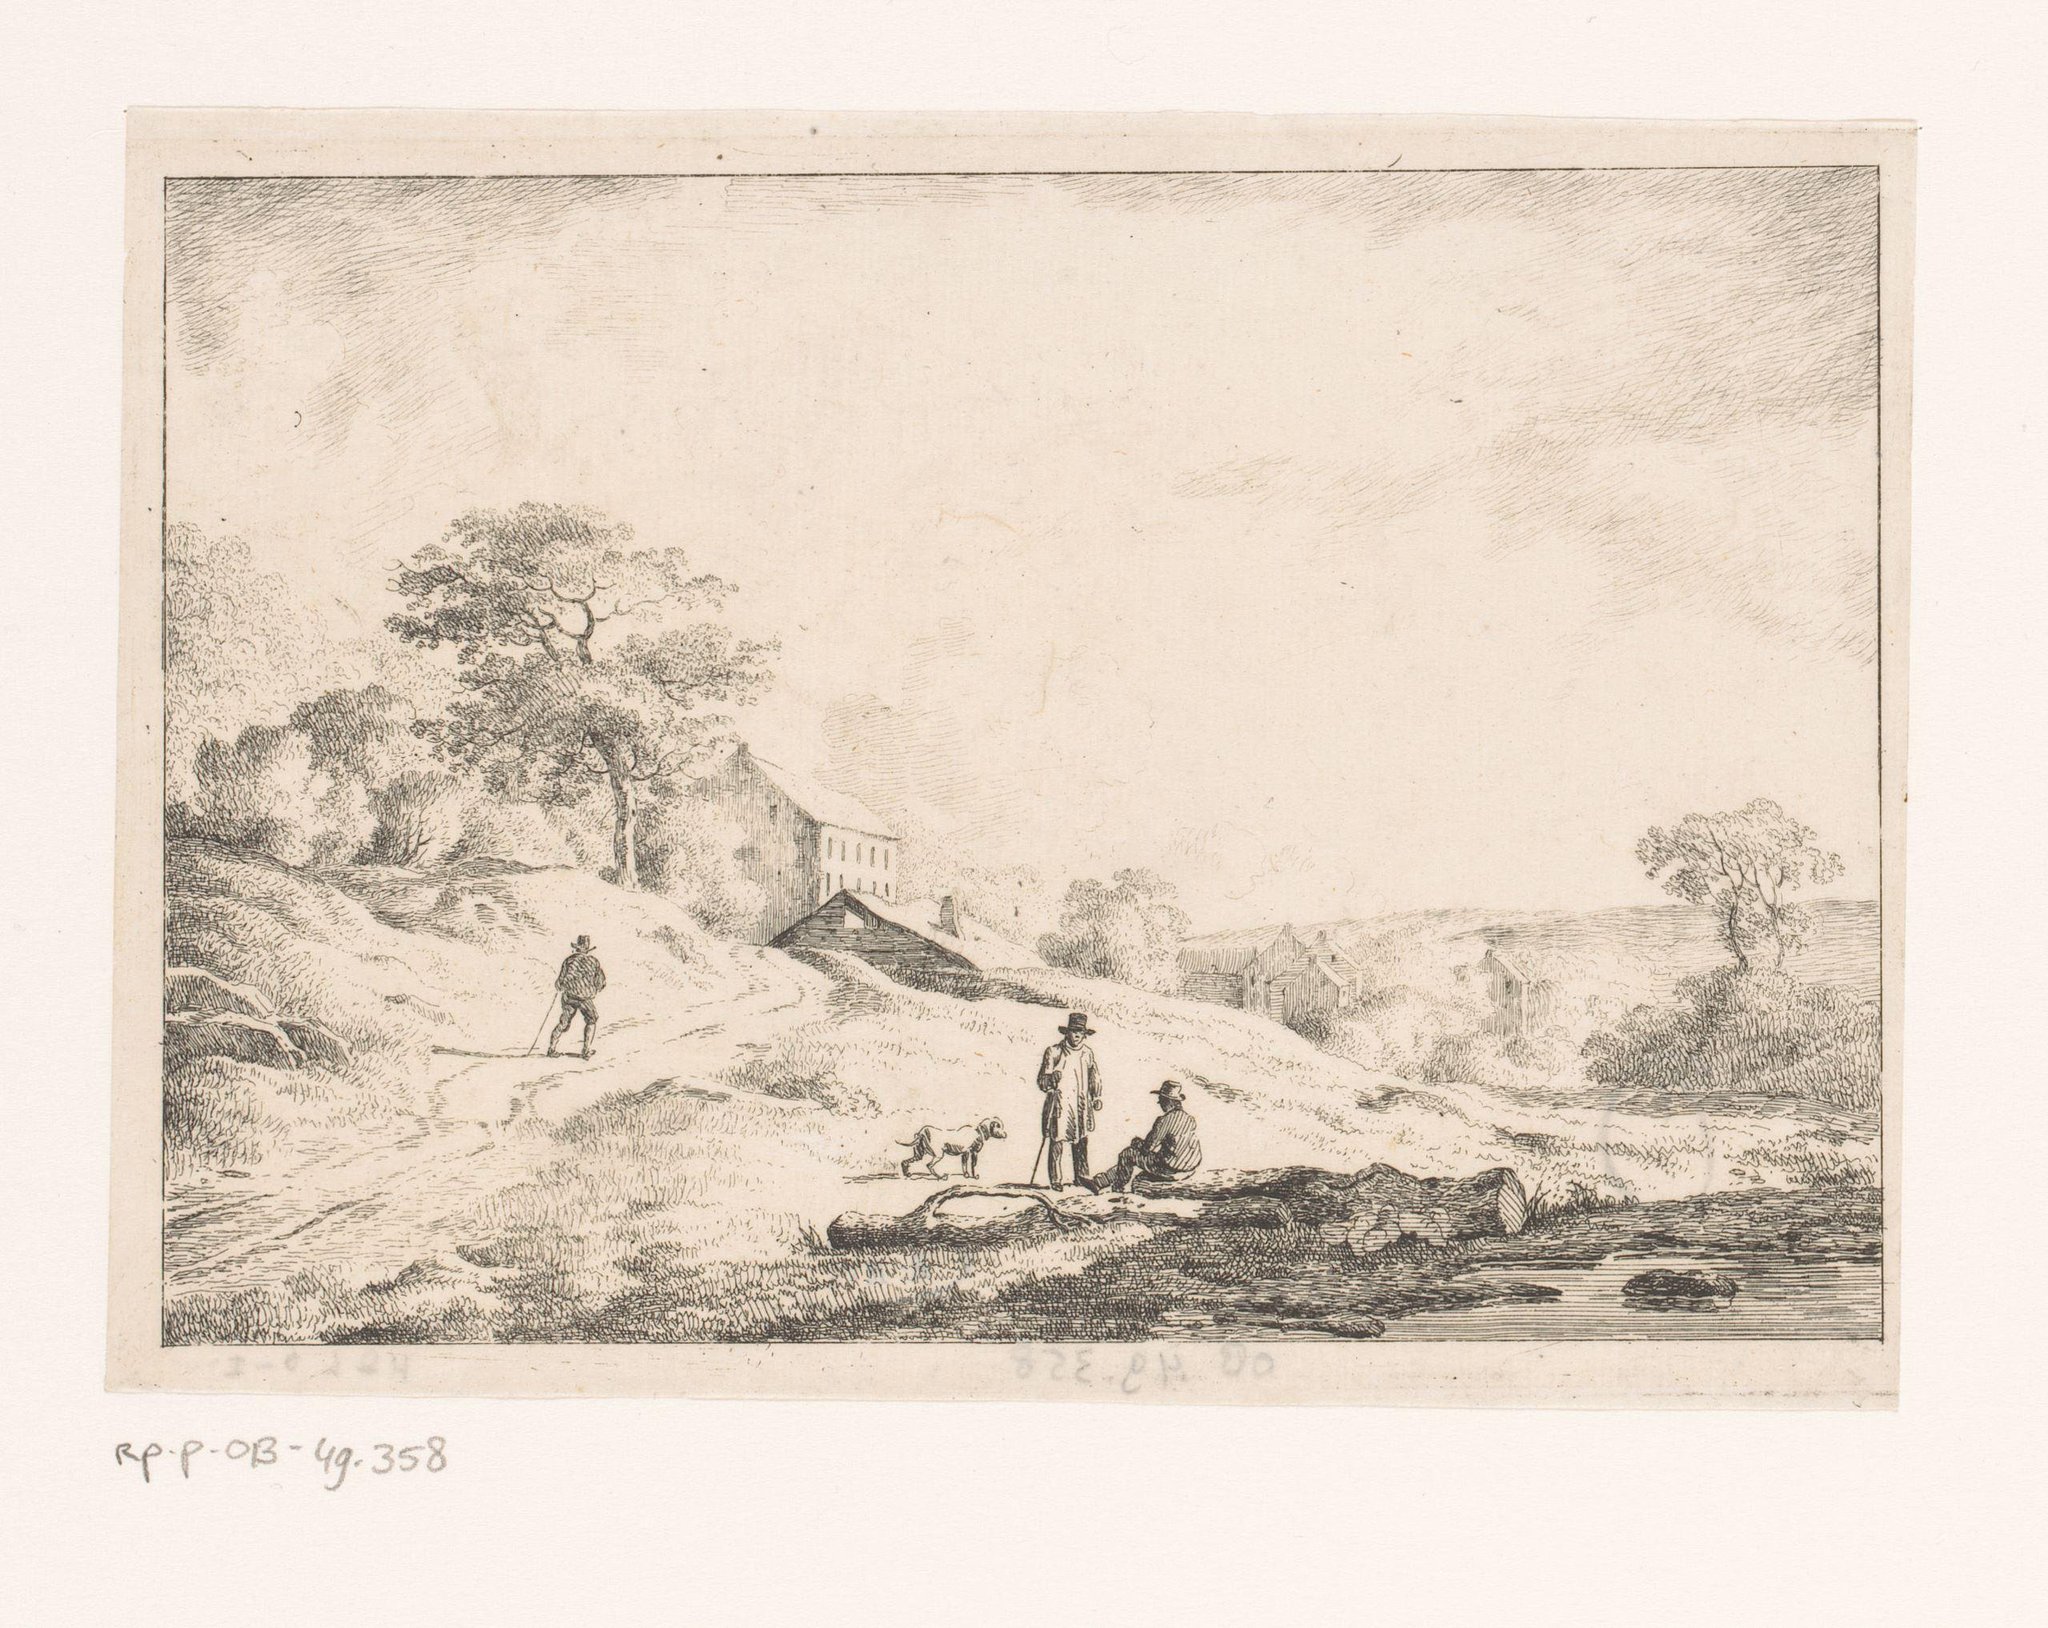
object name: print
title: Heuvellandschap met figuren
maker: auguste herman marie de noter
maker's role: print maker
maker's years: 1806-1838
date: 1831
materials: paper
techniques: etching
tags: low hill country (+ landscape with figures, staffage), dog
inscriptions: collector's mark: Lugt 2228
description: Twee figuren op de voorgrond zijn met elkaar in gesprek.